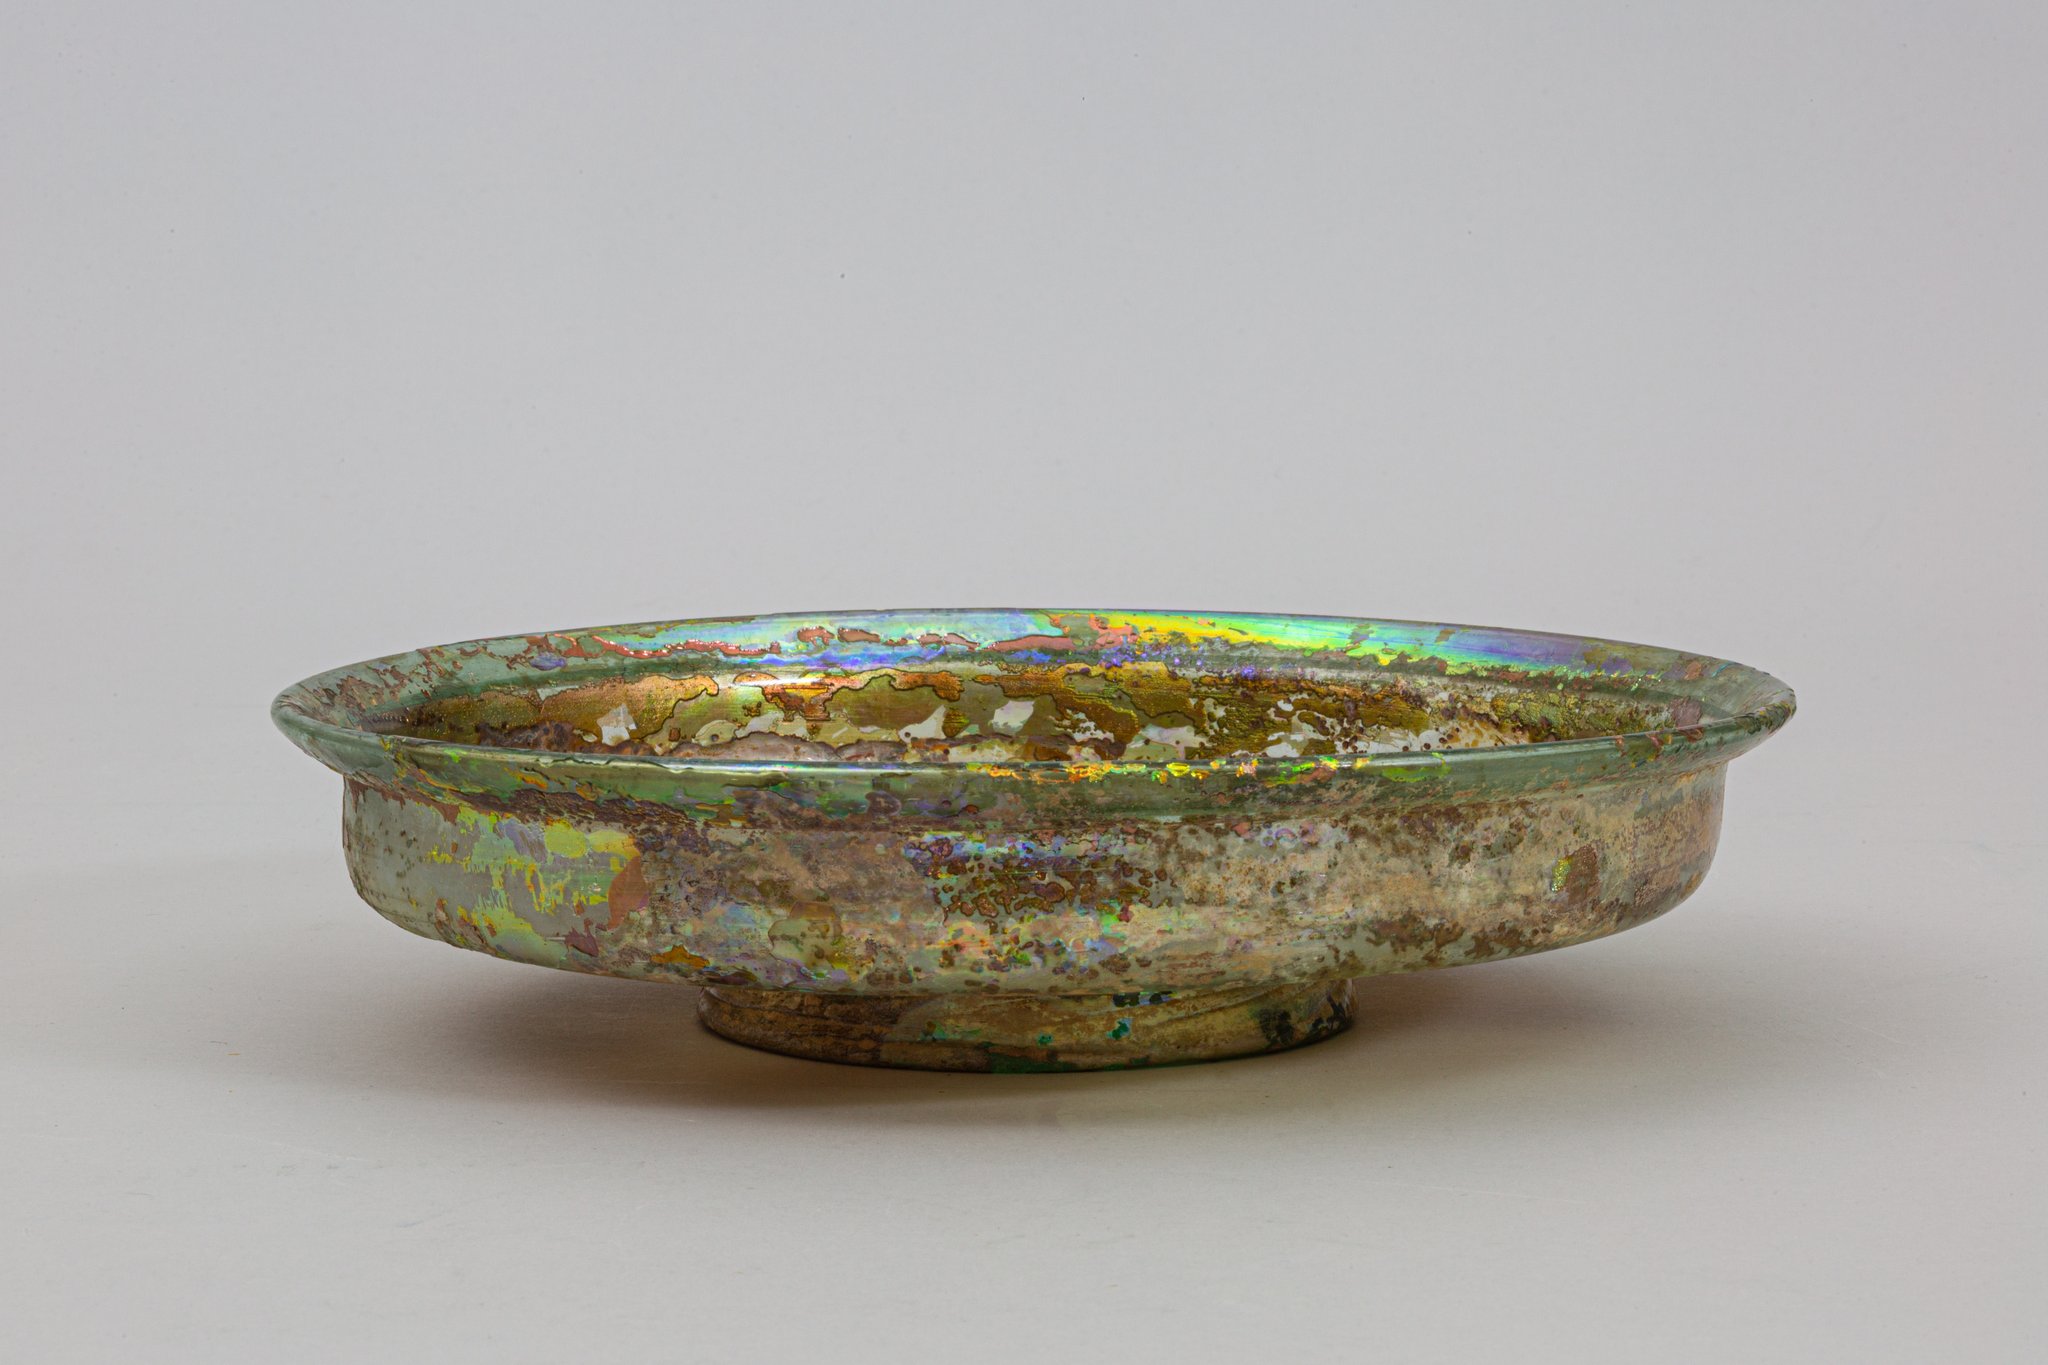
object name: dish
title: Glass dish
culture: roman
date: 201-400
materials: glass